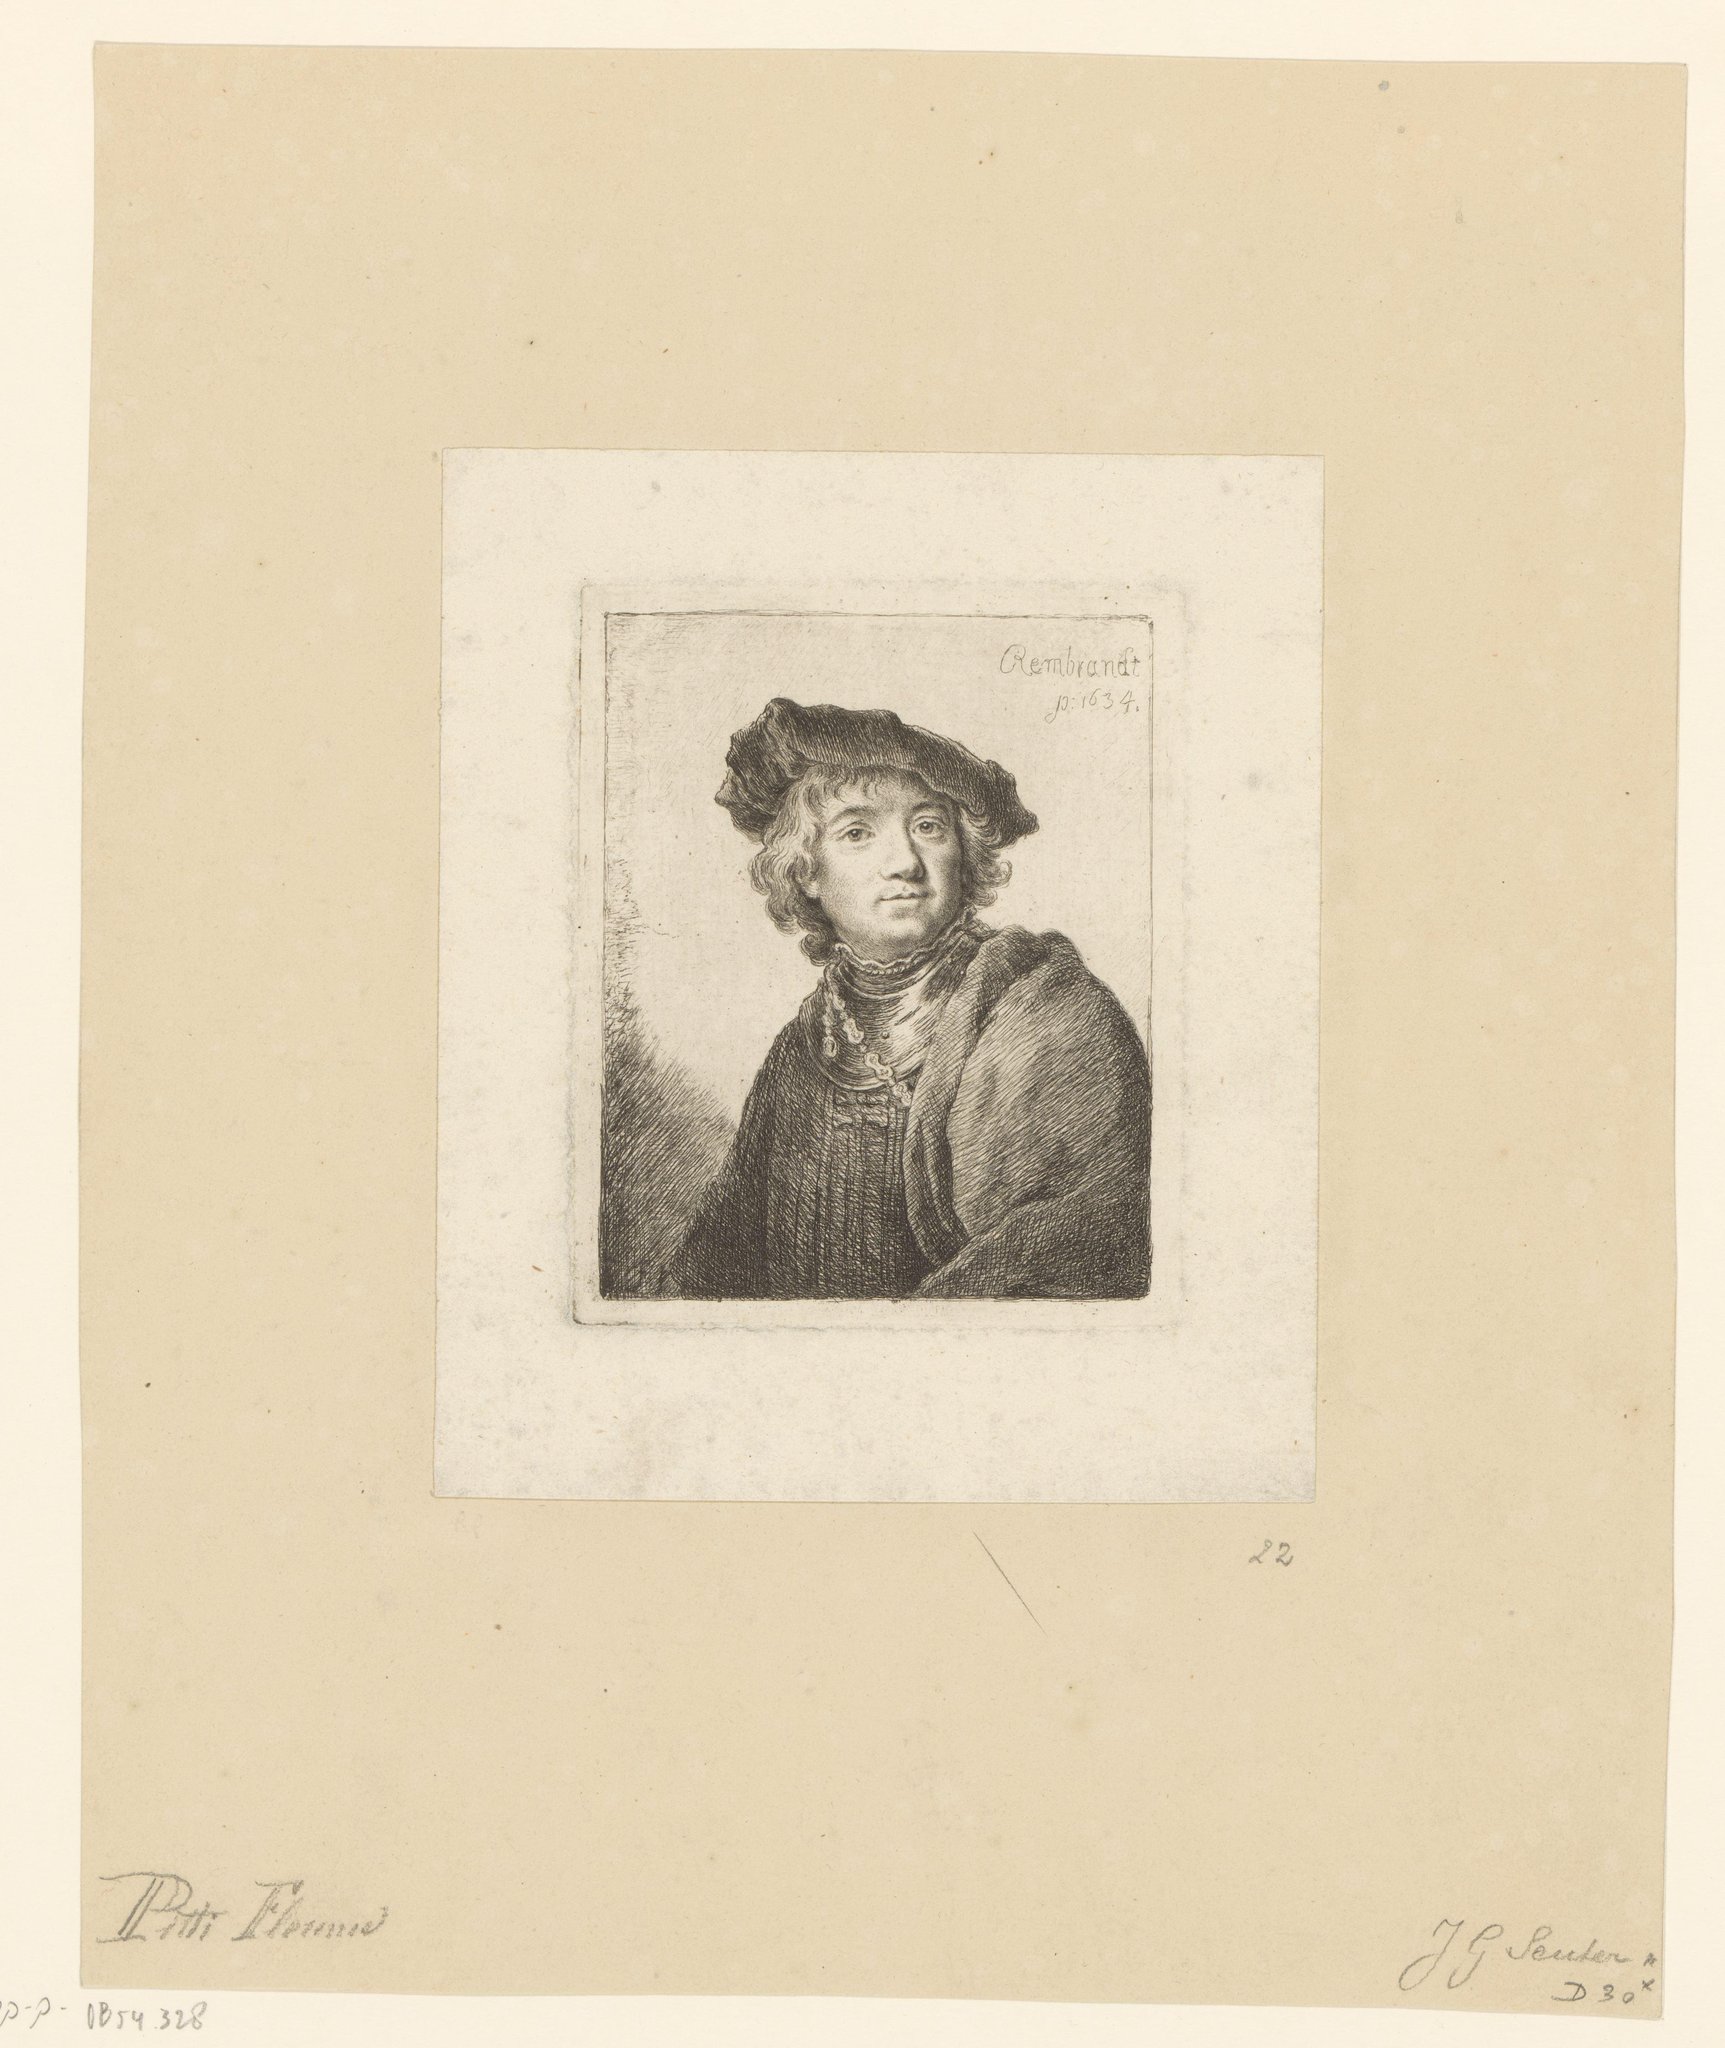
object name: print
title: Portret van Rembrandt Harmensz. van Rijn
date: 1727-1800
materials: paper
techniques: etching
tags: leiden, amsterdam, painter, print maker, draughtsman, rembrandt van rijn, youth, adolescent, portrait, self-portrait of artist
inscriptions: collector's mark: Lugt 240